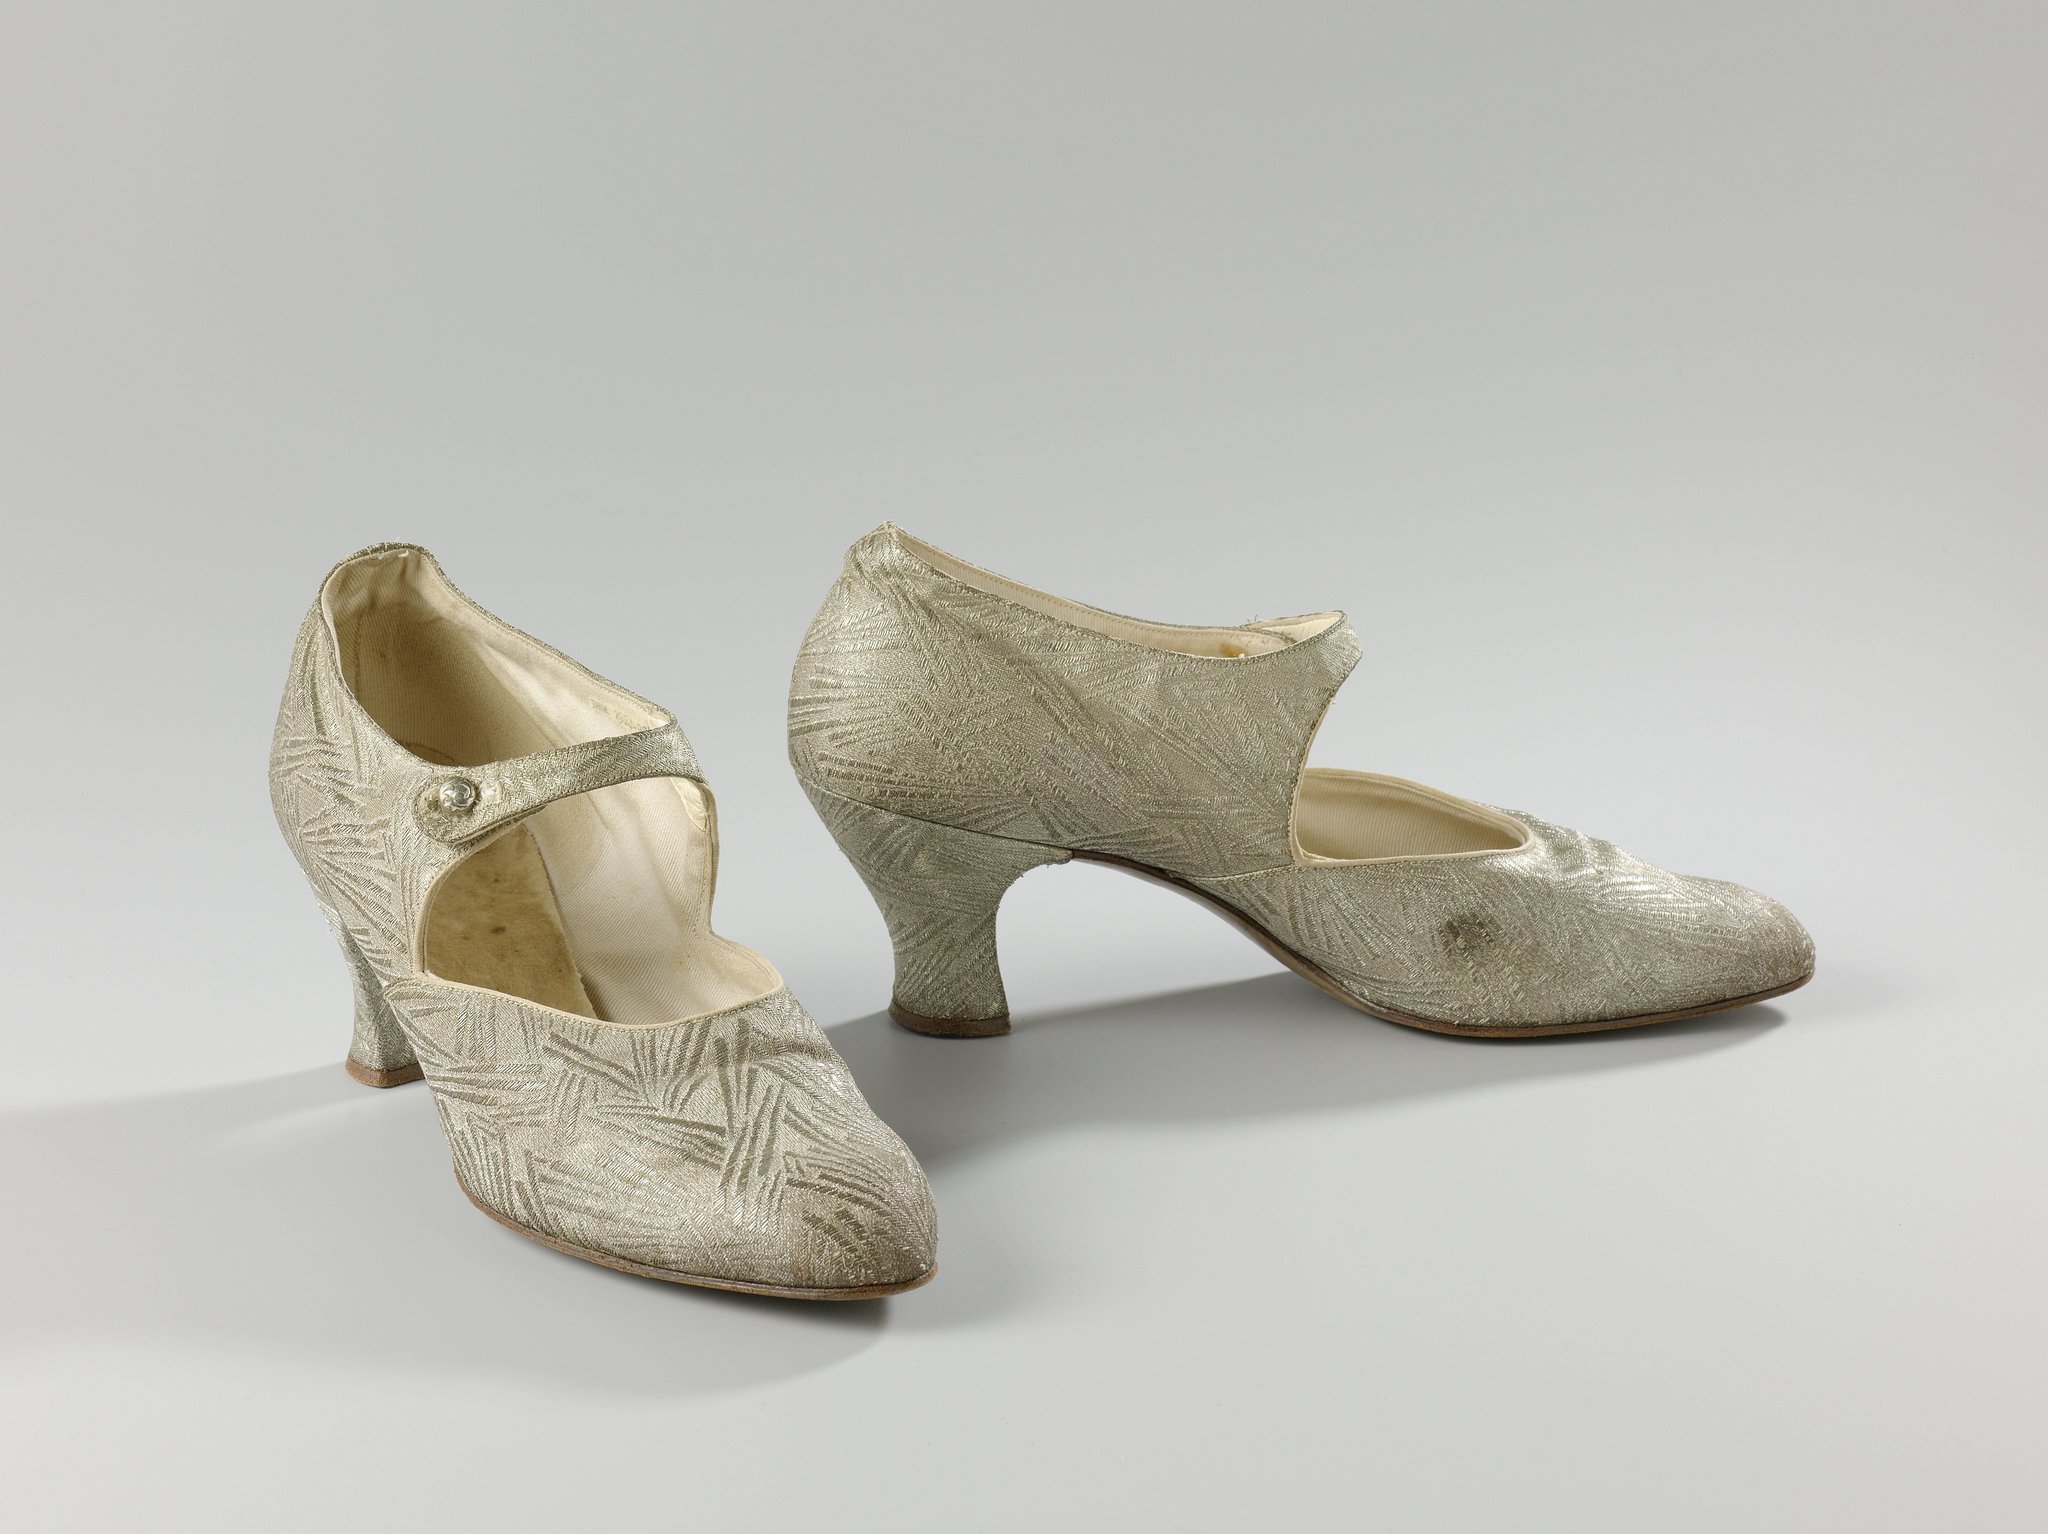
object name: womenswear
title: Damesschoen van zilverbrokaat met enkelband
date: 1928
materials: cotton, felt, iron, leather, metal, silk, thread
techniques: tanning, weave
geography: switzerland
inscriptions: size: ‘6- // 5’, company name: ‘Bally // importé de Suisse’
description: Damesschoen van zilverbrokaat met enkelband. Model: Afgeronde spitse neus, één voorblad en twee zijbladen. De uitsnijding van het voorblad loopt tot halverwege aan het geleng. De zijbladen staan haaks op het voorblad. Aan het rechterzijblad is een enkelband bevestigd. Op het linkerzijblad is, via een metalen oog, een zilverkleurig bewerkte knoop bevestigd. De voorkant van de hak loopt in een afgeronde hoek recht naar beneden. De zijkant en achterkant van de smalle hak zijn getailleerd en bekleed met zilverbrokaat. De hak heeft een bruine rand leer van het achterlapje. Leren achterlapje met vijf spijkers aan de hak vastgeslagen en leren zool. Zijbladen en voorblad gevoerd met crèmekleurig geribd katoen. Enkelband gevoerd met ivoorkleurig leer. De binnenzool is van crèmekleurig vilt geplakt op een harde zool. UItsnijding van de voorvoet afgebiesd met beige ripsband.